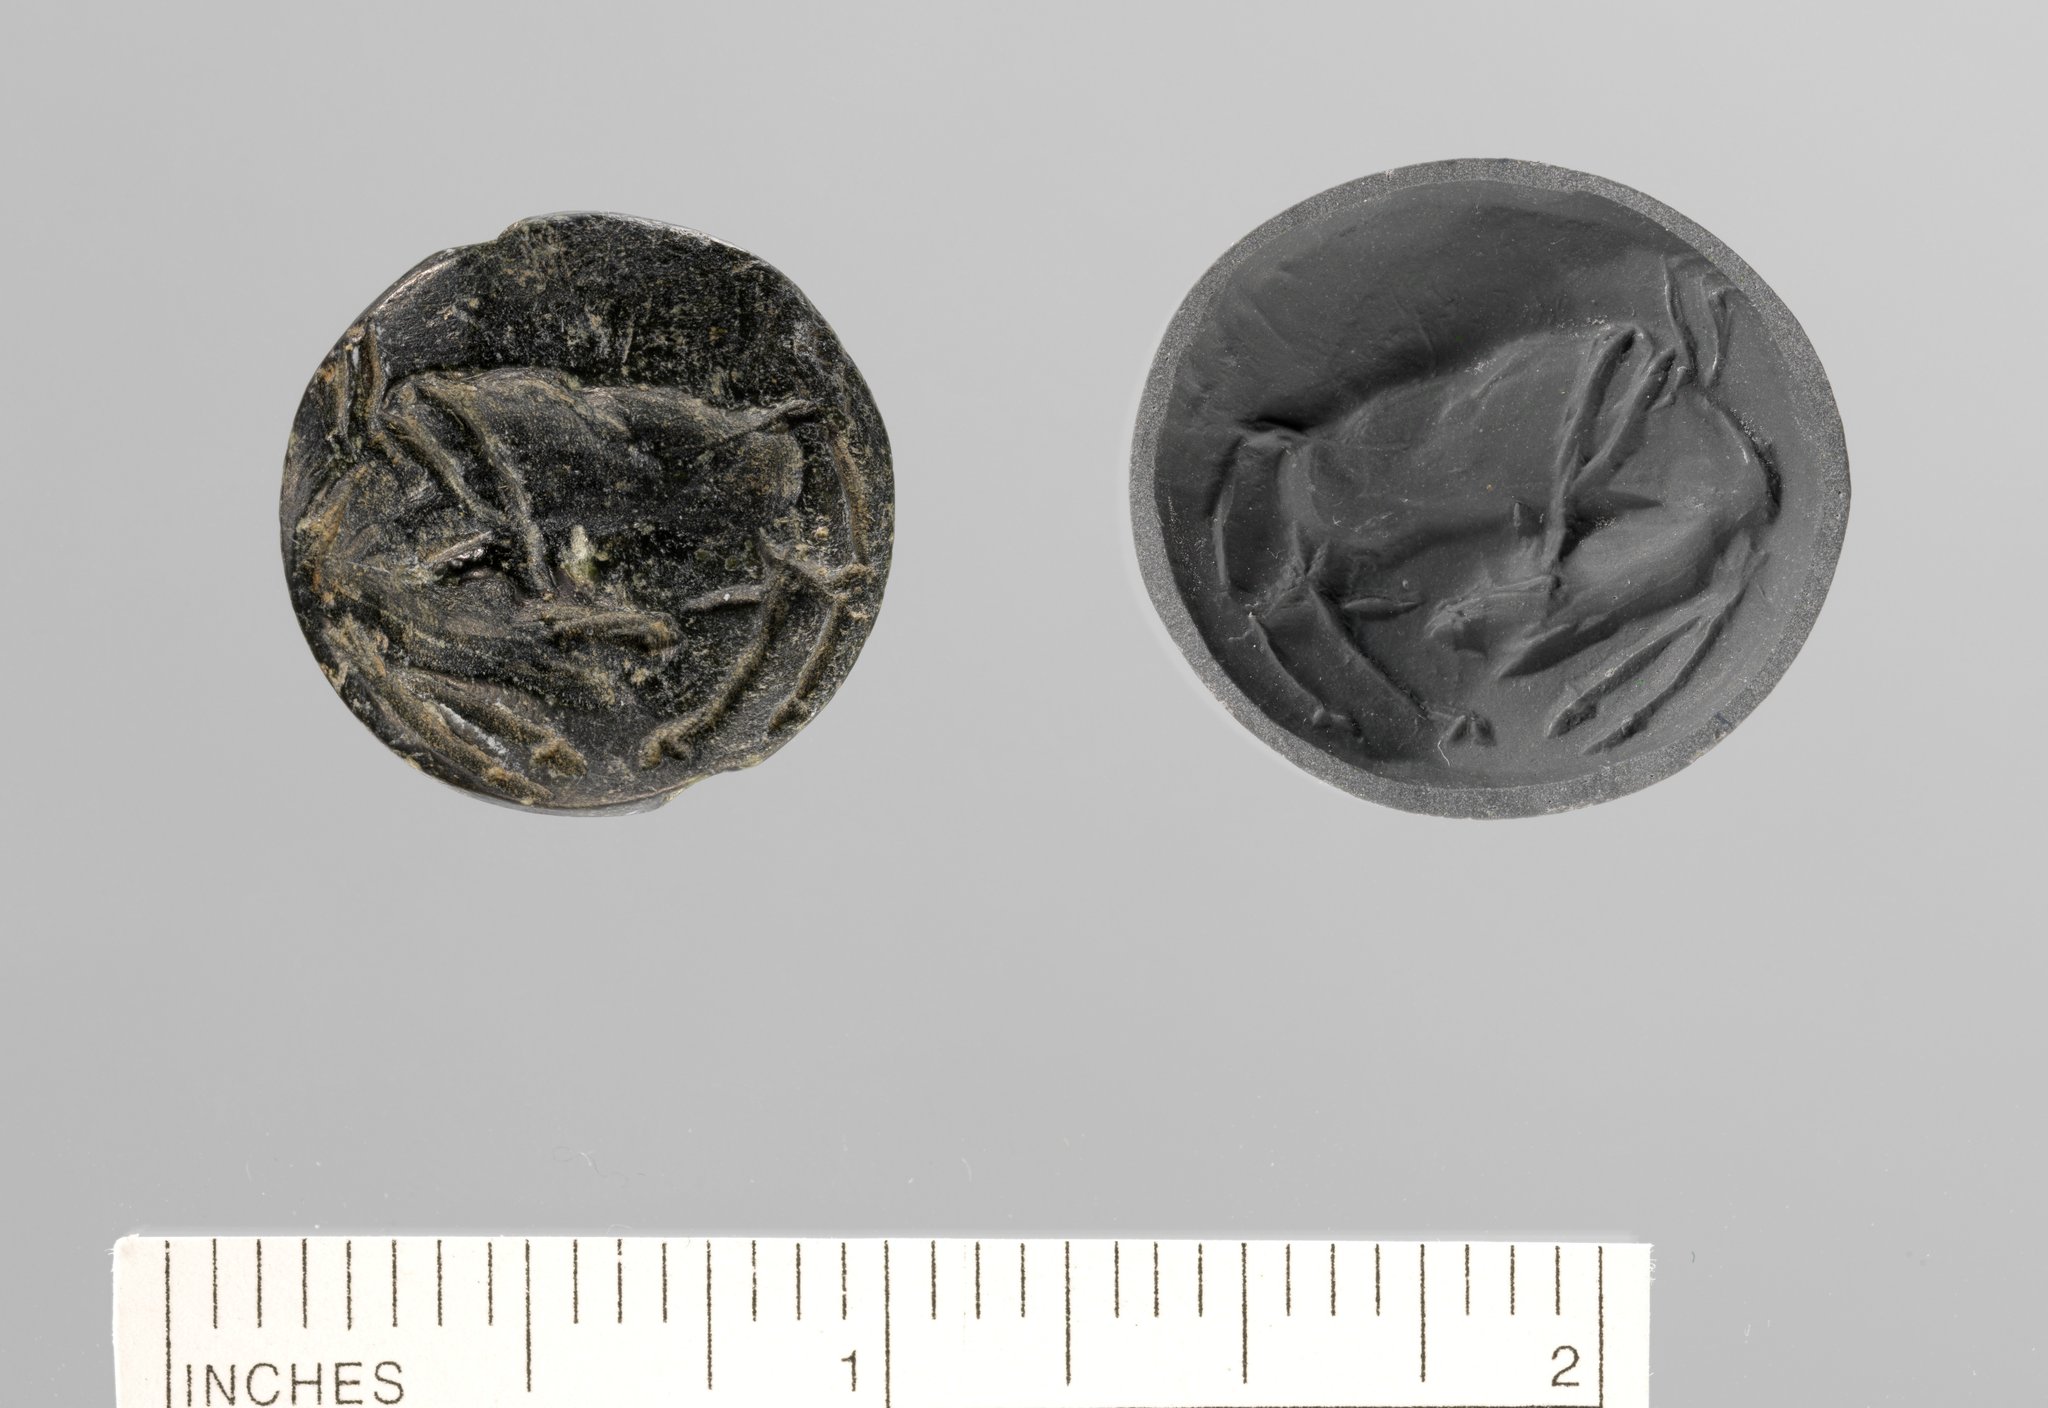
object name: seal, lentoid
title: Marble Lentoid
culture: minoan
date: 1400-1200 BCE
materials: marble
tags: bulls